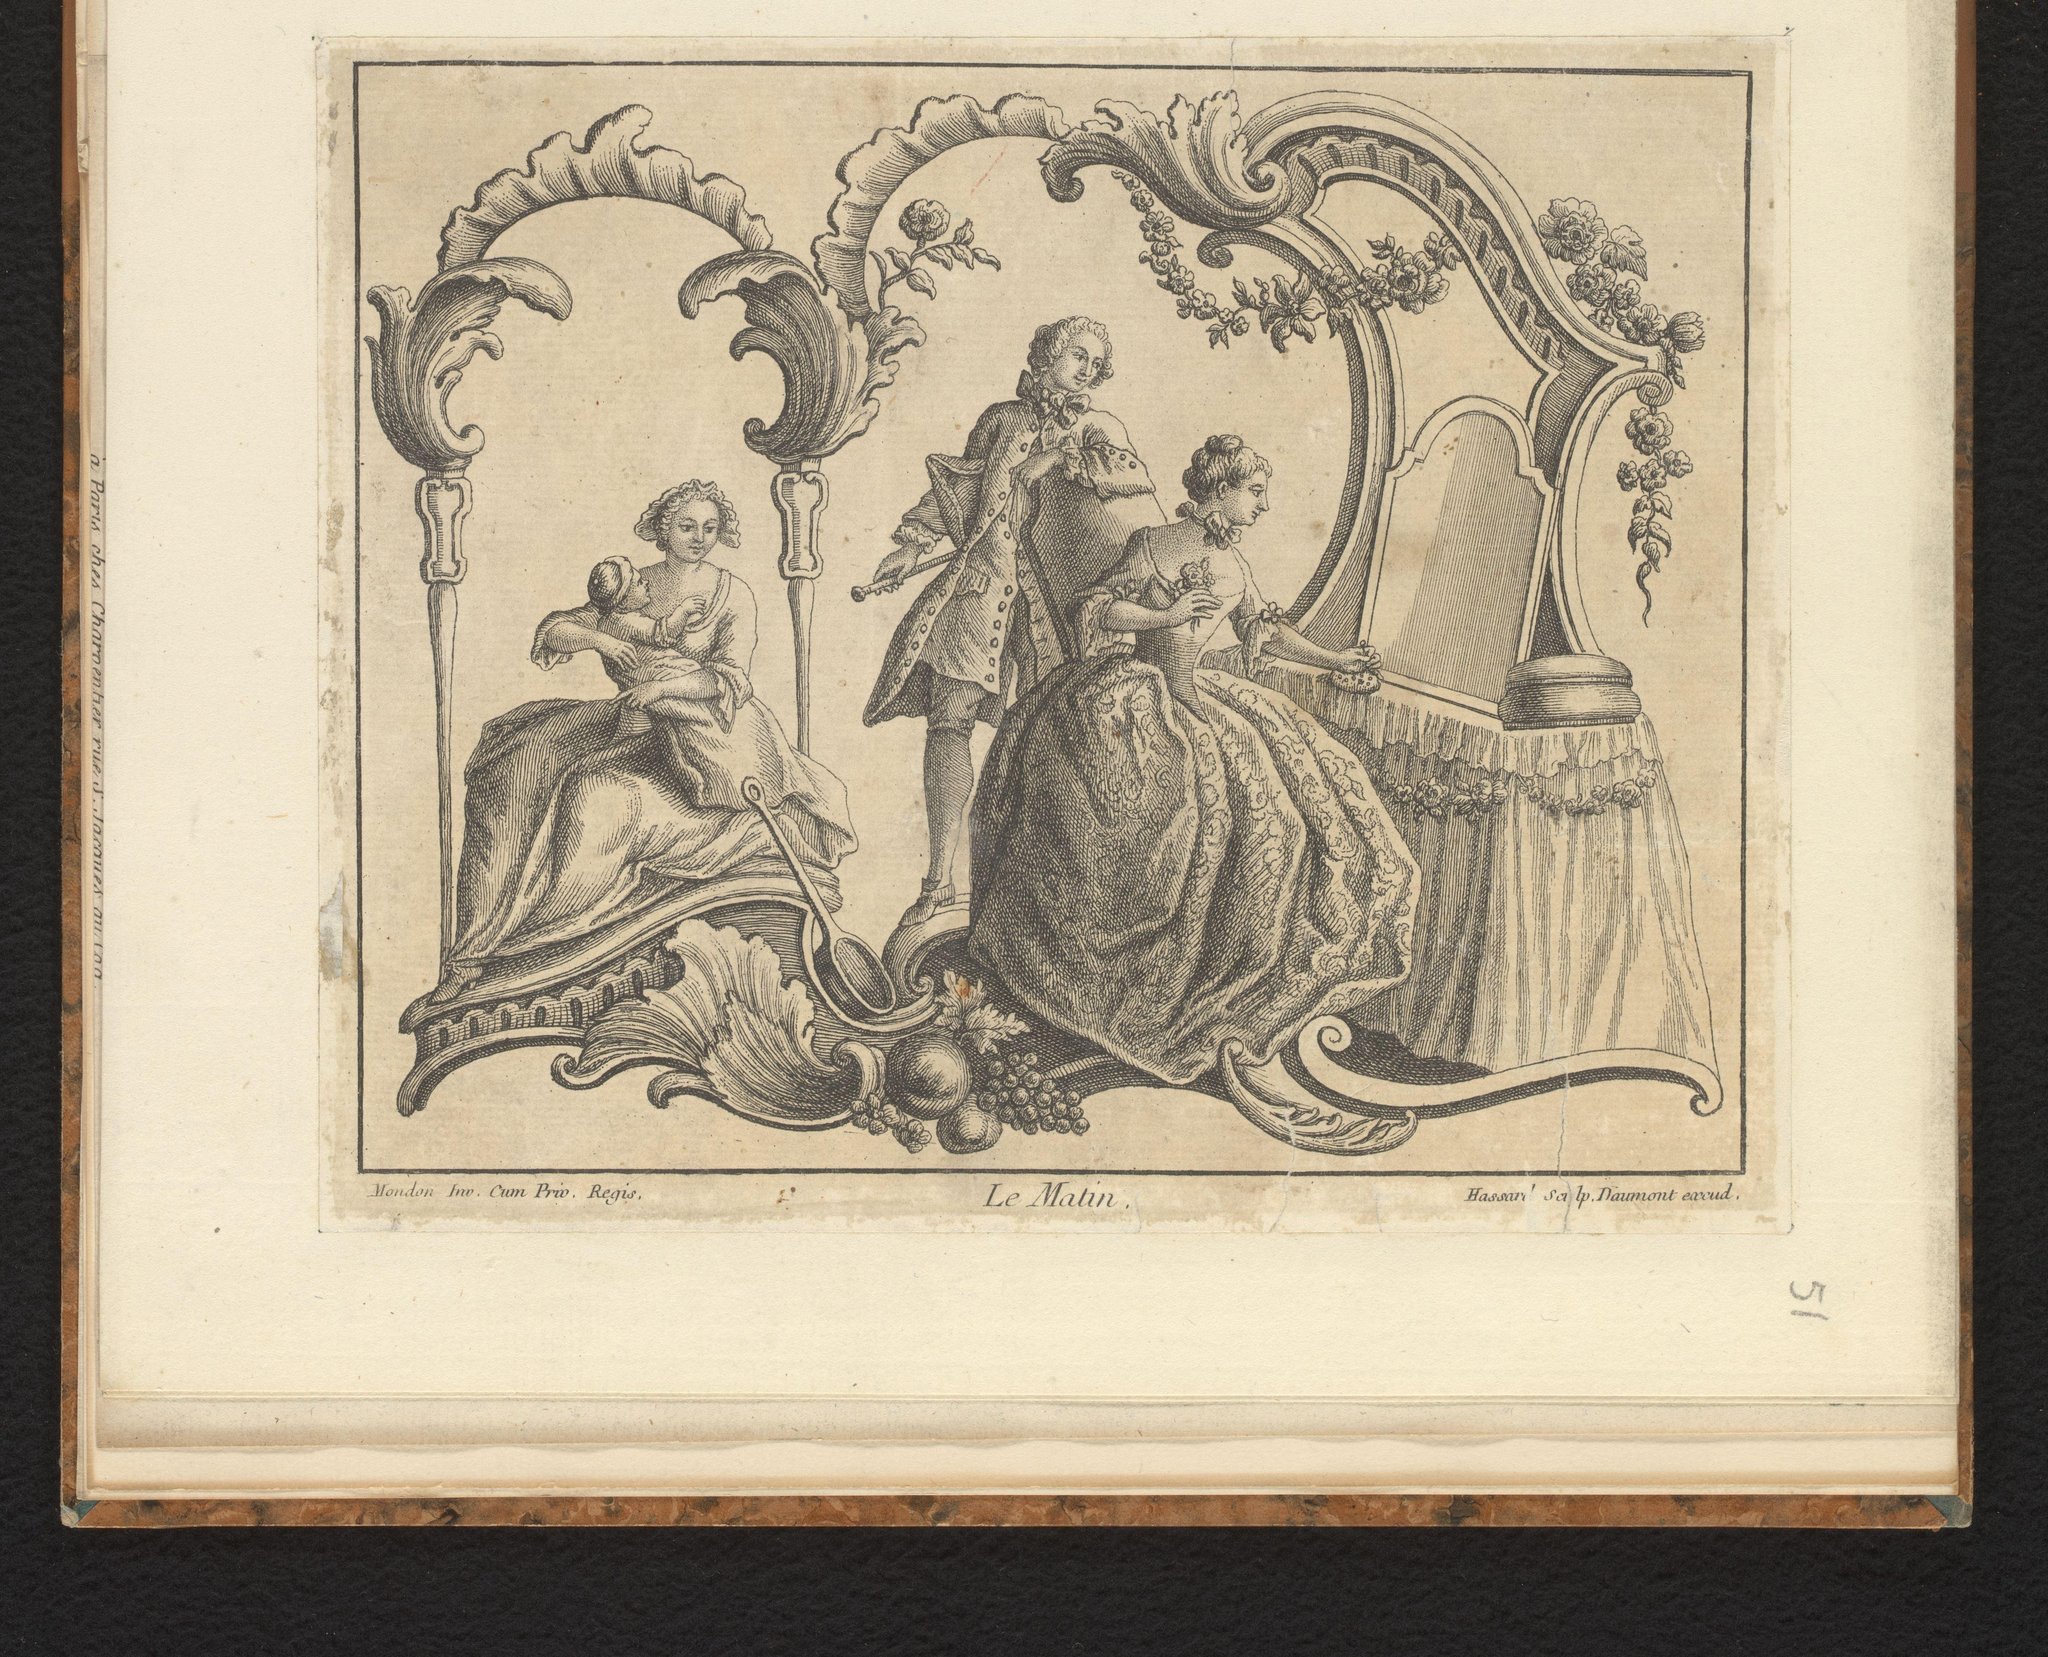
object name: ornament print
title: Rocaille met elegante heer en twee dames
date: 1719-1775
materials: paper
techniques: etching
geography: paris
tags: making toilet, rocaille ornament, morning